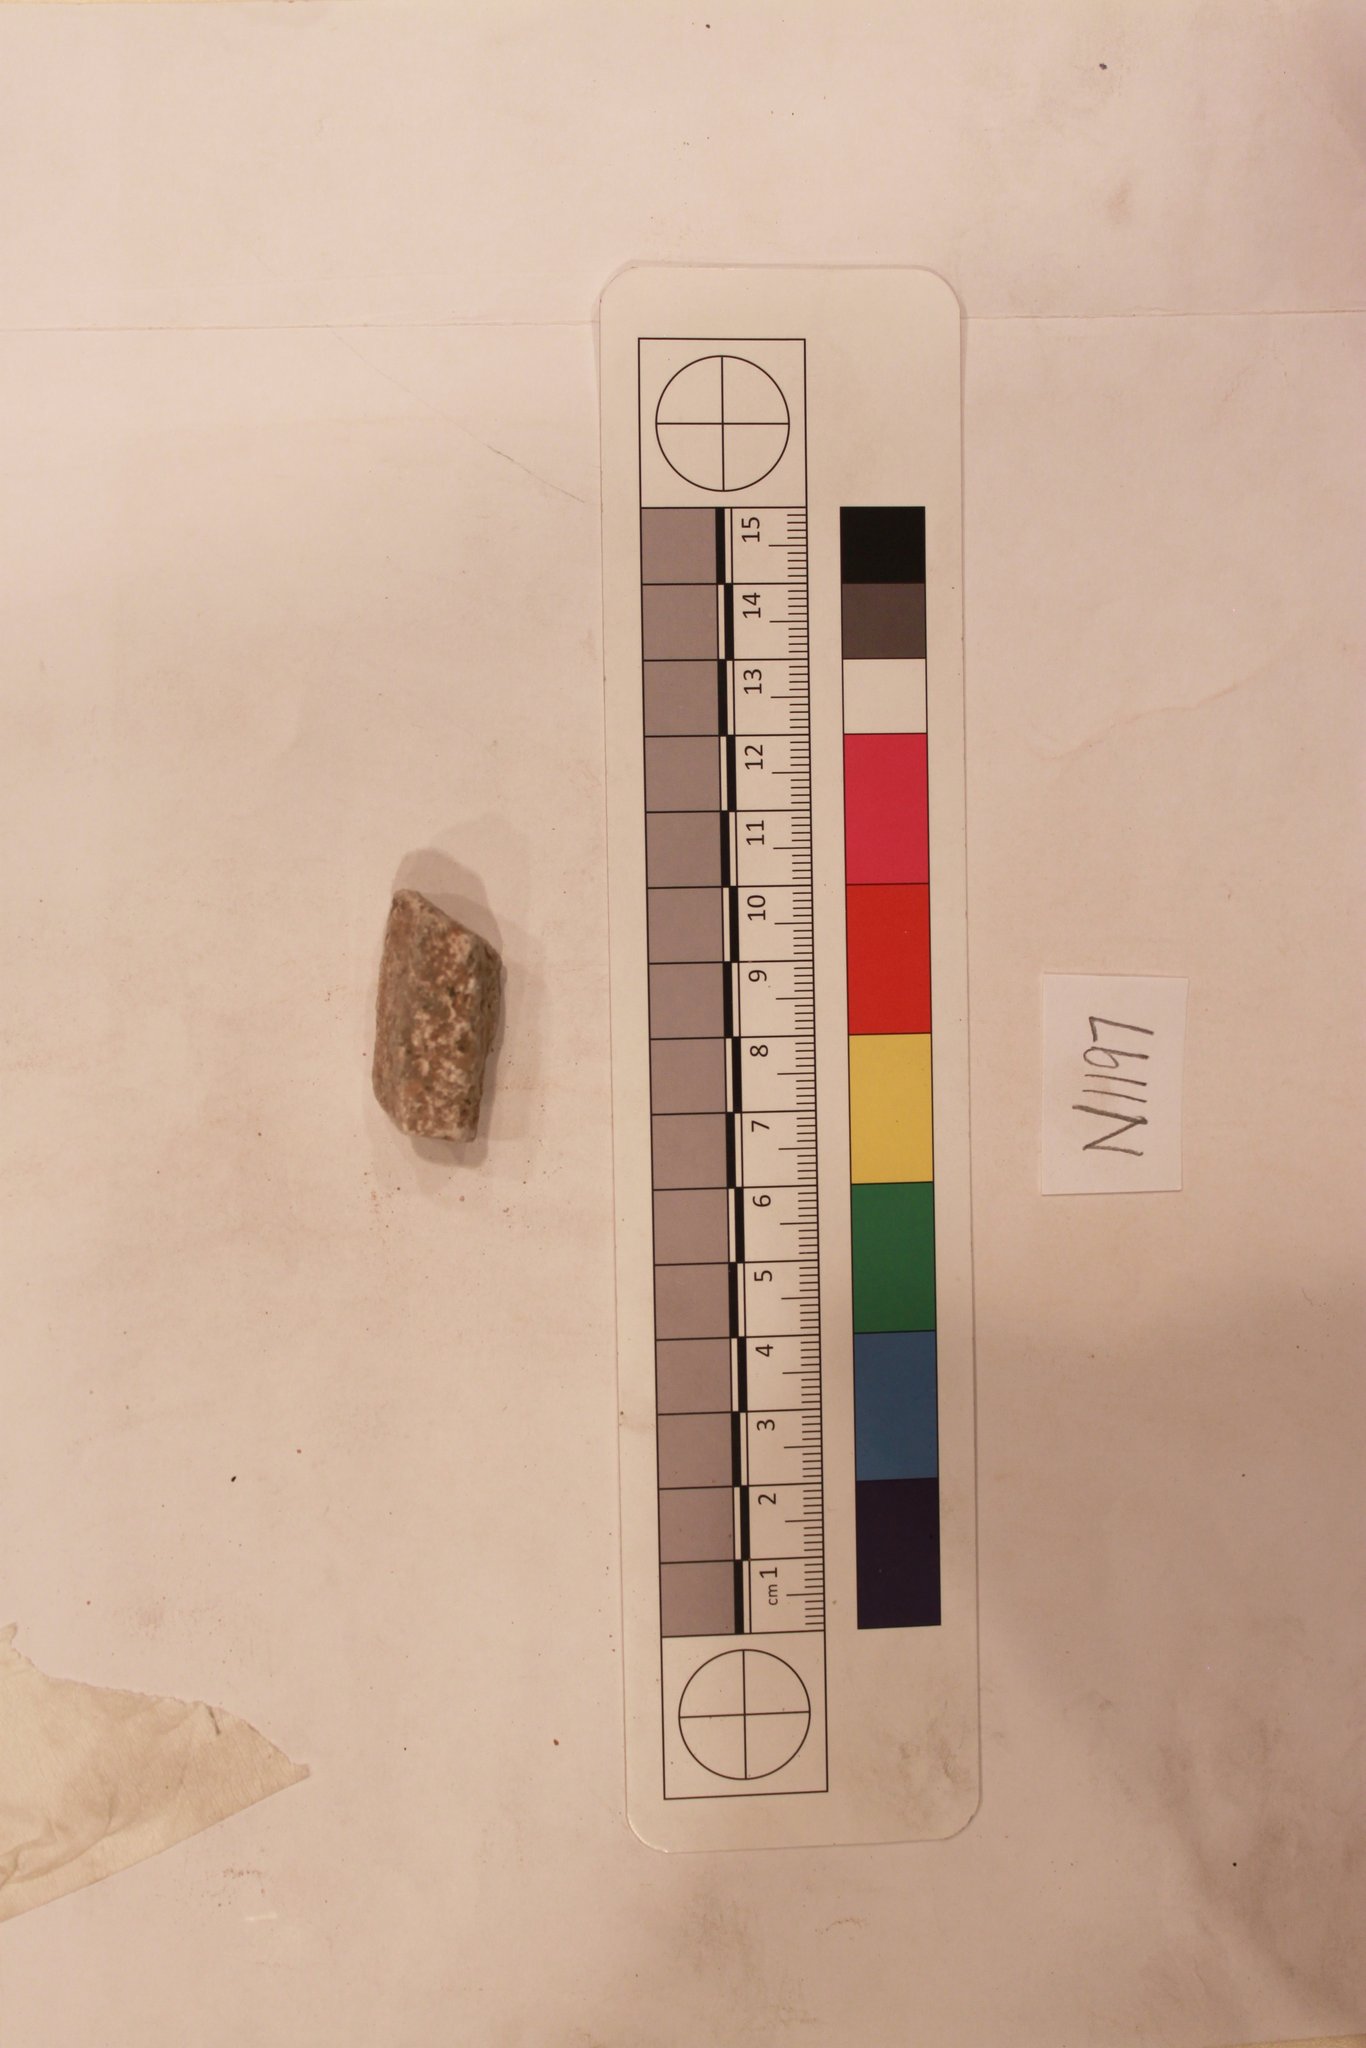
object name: fragment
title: Stucco Fragment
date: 701-1200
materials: plaster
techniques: carving, painting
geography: iran